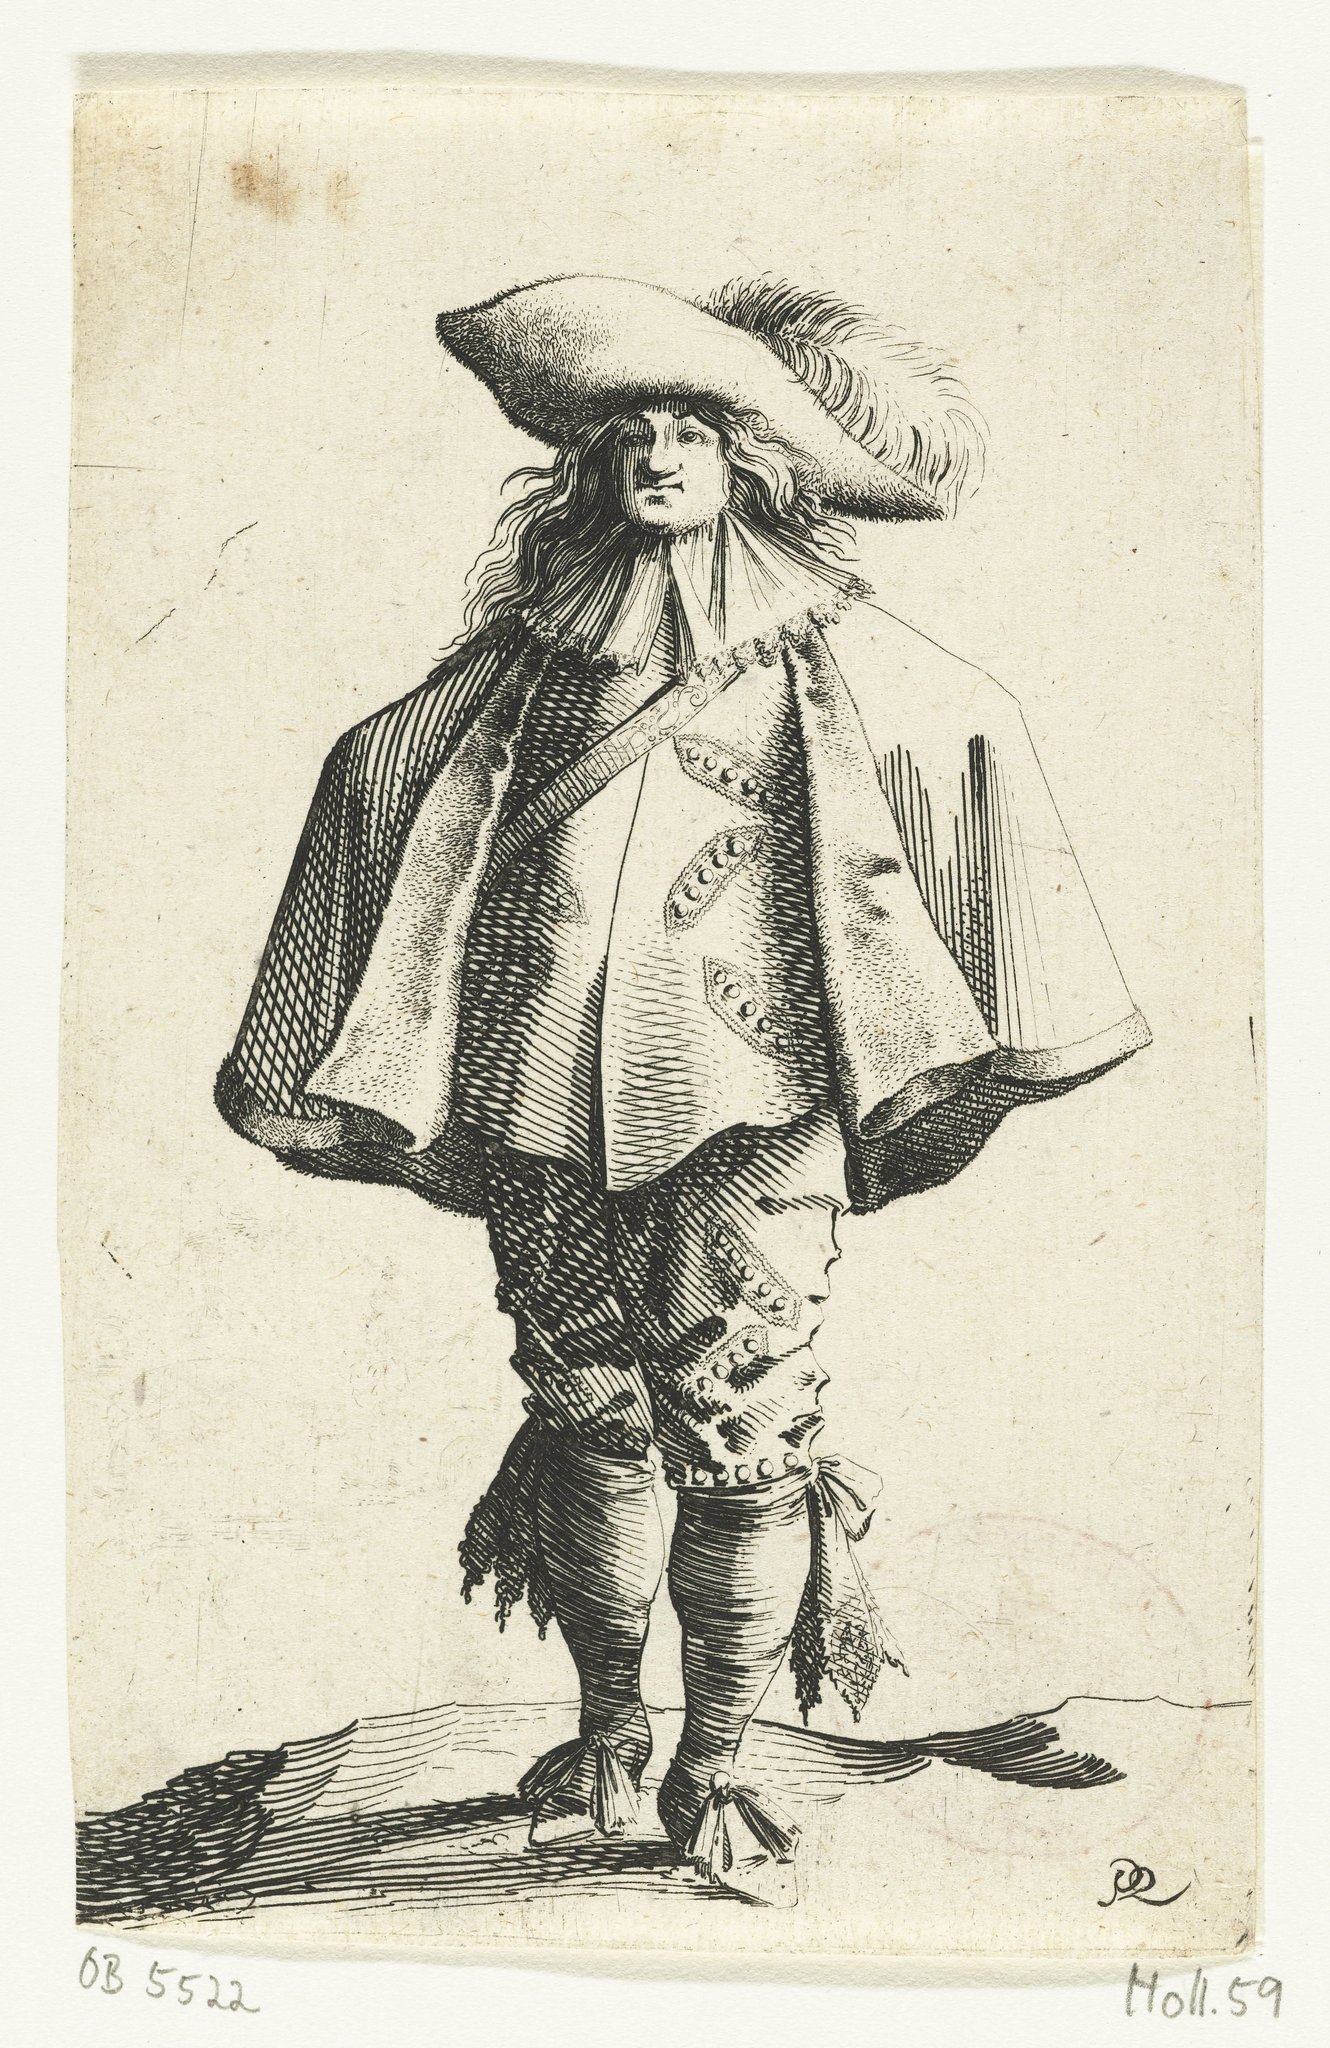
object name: costume print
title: Staande cavalier met cape en gepluimde hoed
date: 1633-1665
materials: paper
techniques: engraving, etching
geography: amsterdam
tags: warfare; military affairs (+ cavalry, horsemen), clothes, costume (+ men's clothes)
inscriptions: collector's mark: Lugt 240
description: De prent maakt deel uit van een tiendelige serie prenten met voorstellingen van cavaliers en welgestelde vrouwen, gekleed volgens de Nederlandse mode ca. 1625-1630.